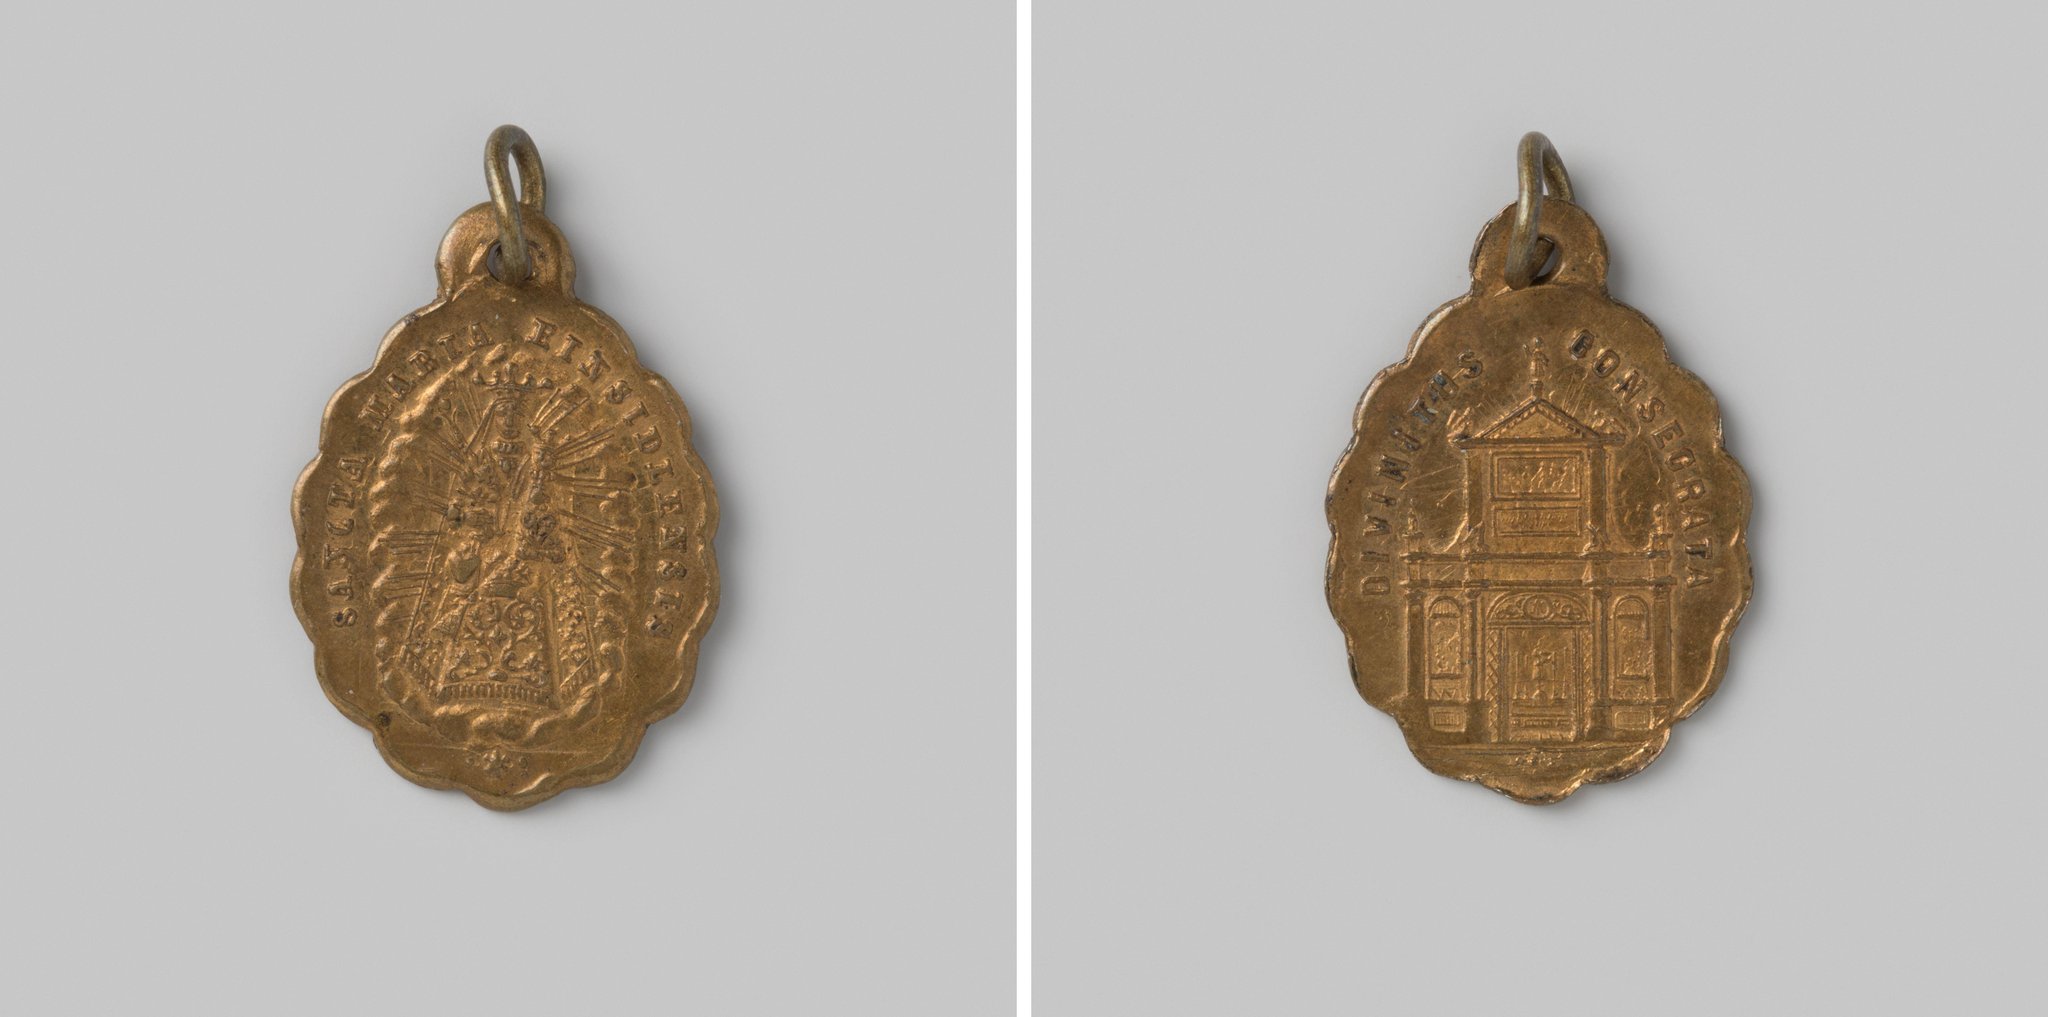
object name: history medal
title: Religieus draagteken met Maria van Einsiedeln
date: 1750-1850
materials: brass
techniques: striking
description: Kleine ovalen messing penning met golvende rand, met oog en draagring, op de voorzijde Maria van Einsiedeln met omschrift, op de keerzijde het aanzicht van een kerk met omschrift.